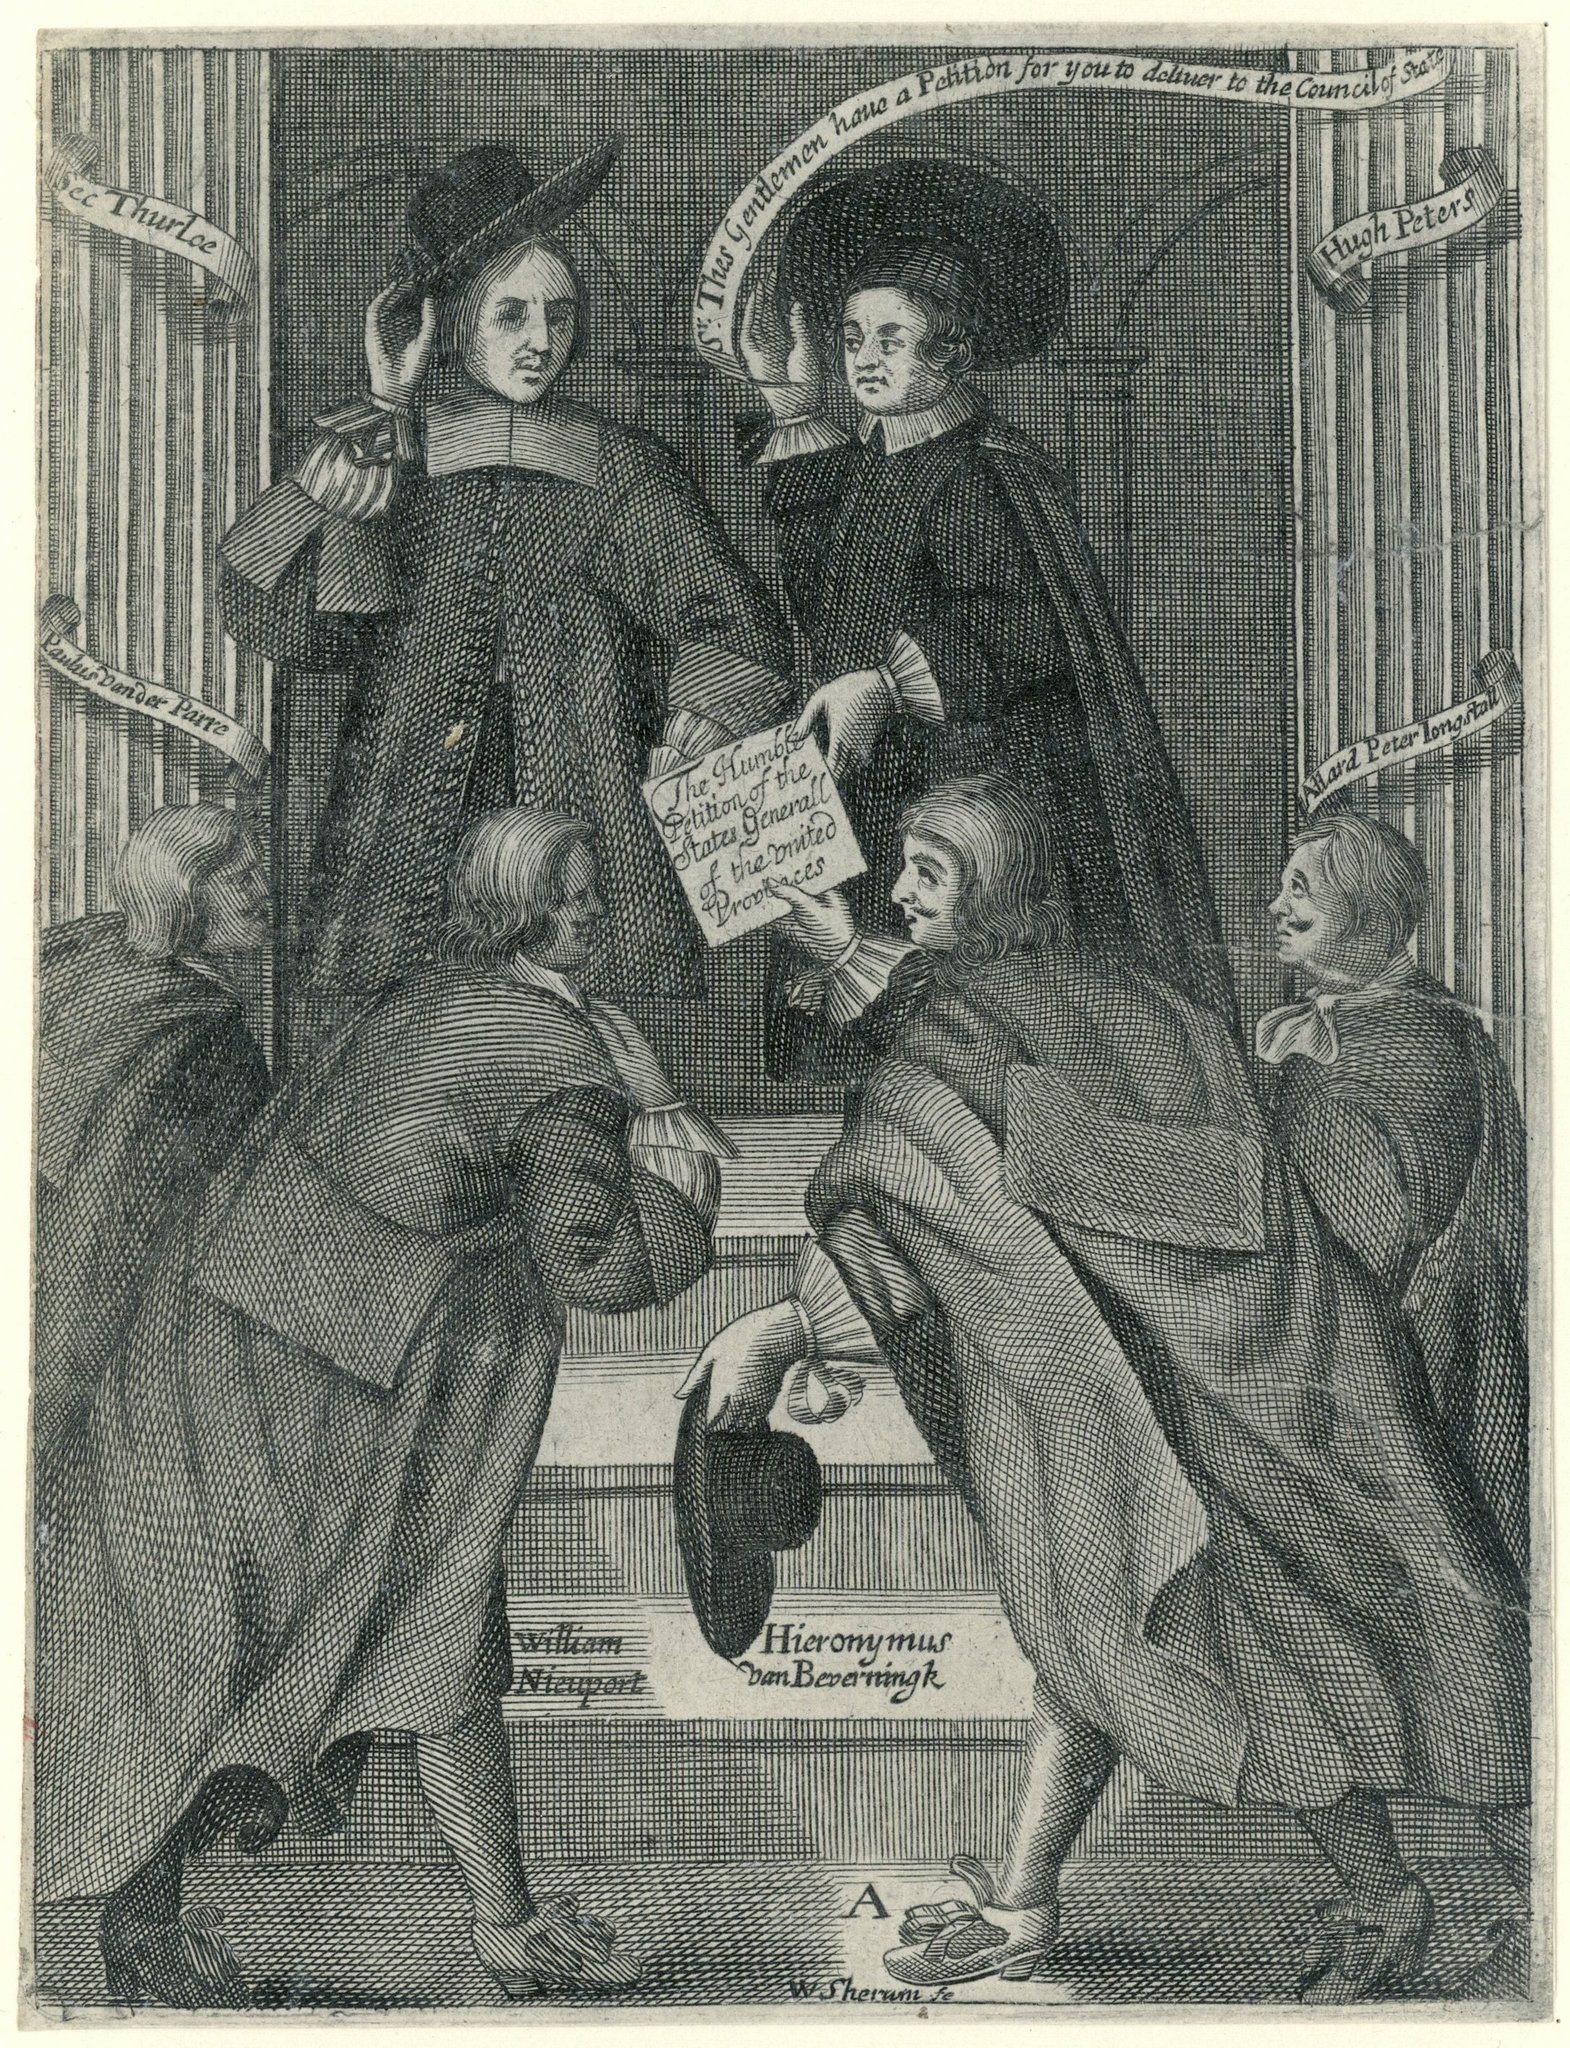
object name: propagandaprent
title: Het aanbieden van een petitie aan de Engelse staatssectretaris, ca. 1654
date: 1673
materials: paper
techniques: engraving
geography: london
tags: staatsman, diplomaat, regent, hieronymus van beverningk, allard peter jongstall, willem nieupoort, paulus van der parre, staatssecretaris, john thurloe, predikant, hugh peters, eerste engelse oorlog, derde engelse oorlog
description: Illustratie gemerkt 'A', afkomstig uit W. Stubbe, 'A Further Justification of the Present War against the United Netherlands', Londen 1673. De voorstelling toont het nederig aanbieden van een petitie aan de Engelse staatssecretaris John Thurloe en Hugh Peters door de afgevaardigden van de Staten-Generaal, in de prent genaamd: Paulus van der Parre, Willem Nieupoort, Hieronymus van Beverningk en Allard Peter Jongstall. Episode ten tijde van de Eerste Engelse Oorlog, ca, 1654. De prenten zijn door de Engelsen gebruikt als propaganda om de oorlog tegen de Verenigde Provincies te rechtvaardigen.